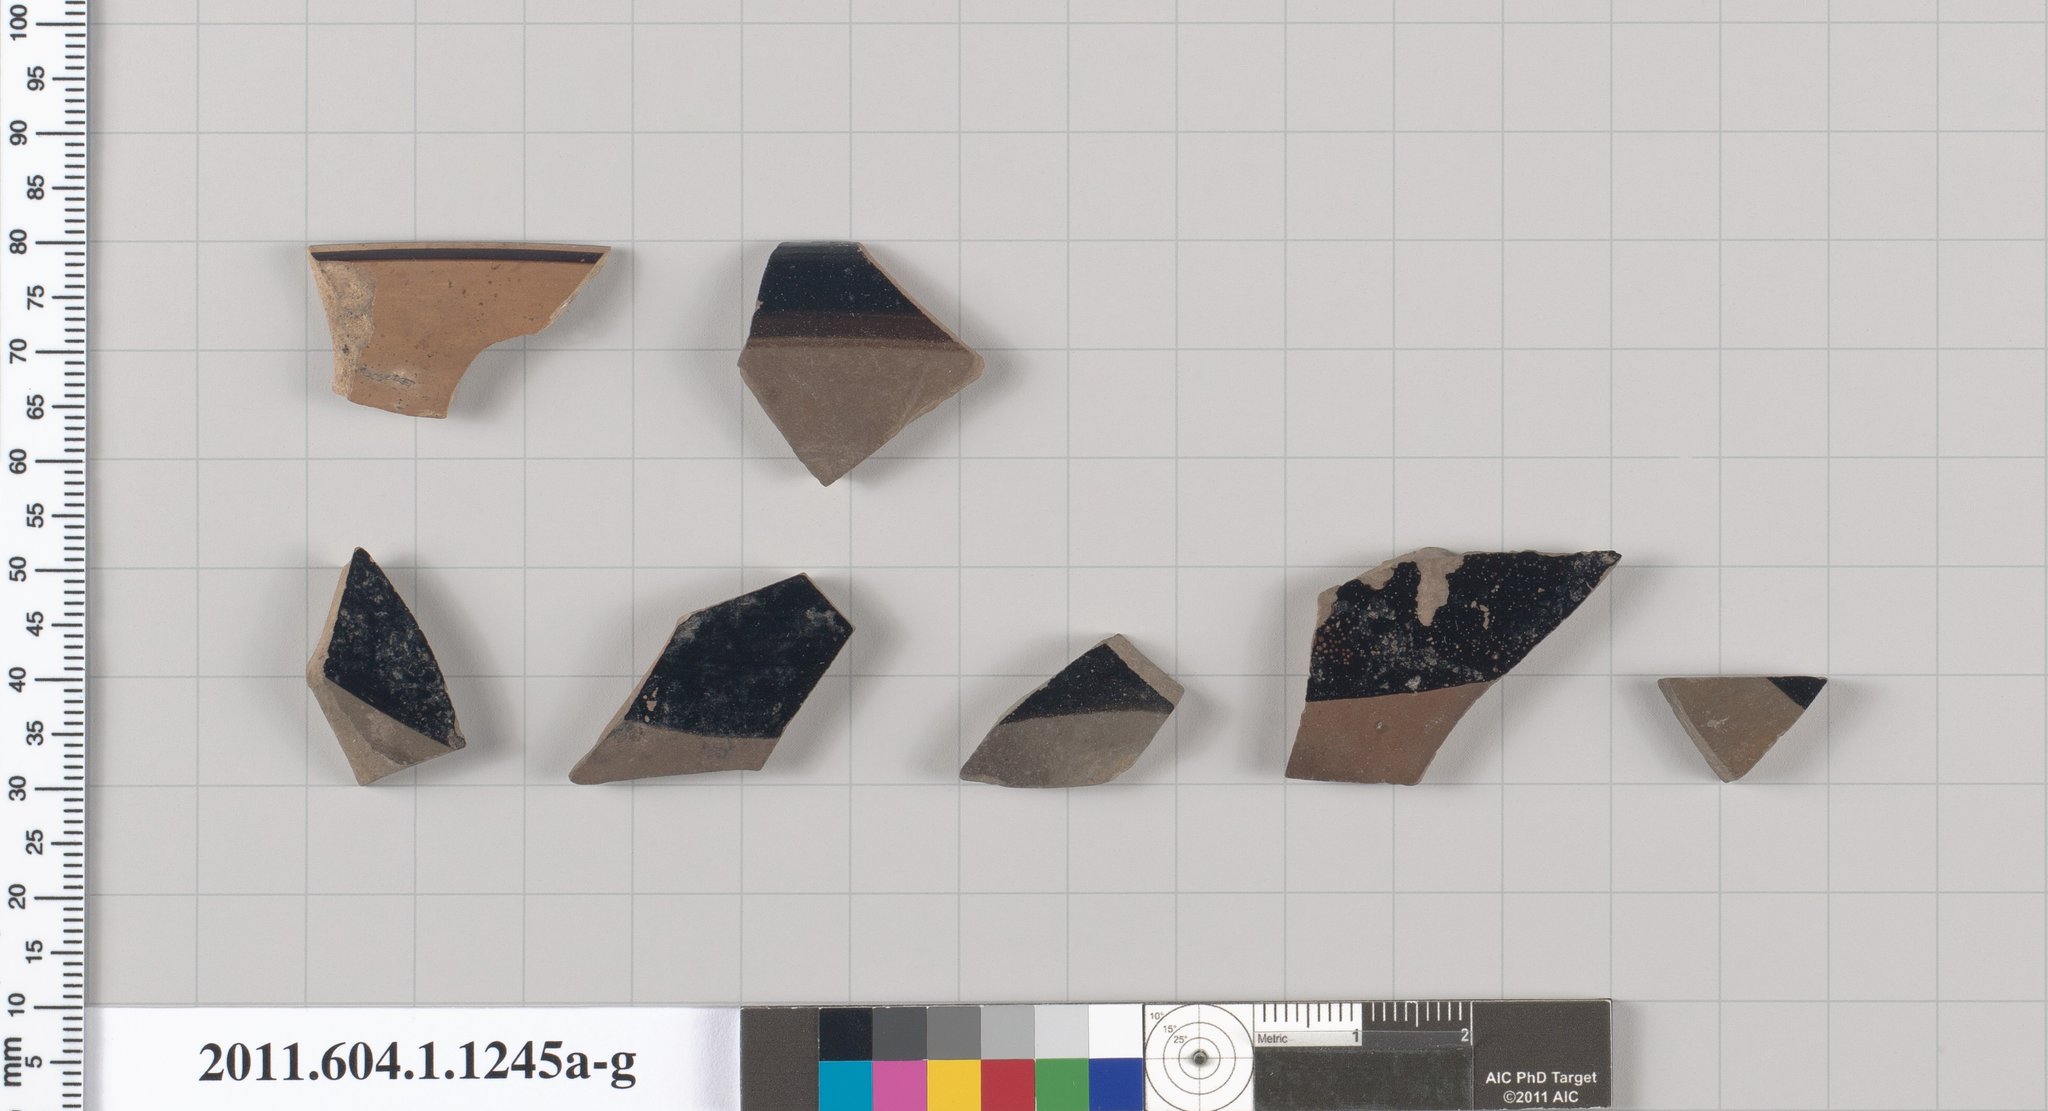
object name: kylix fragment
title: Terracotta fragments of kylikes (drinking cups)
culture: greek, attic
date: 500-401 BCE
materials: terracotta